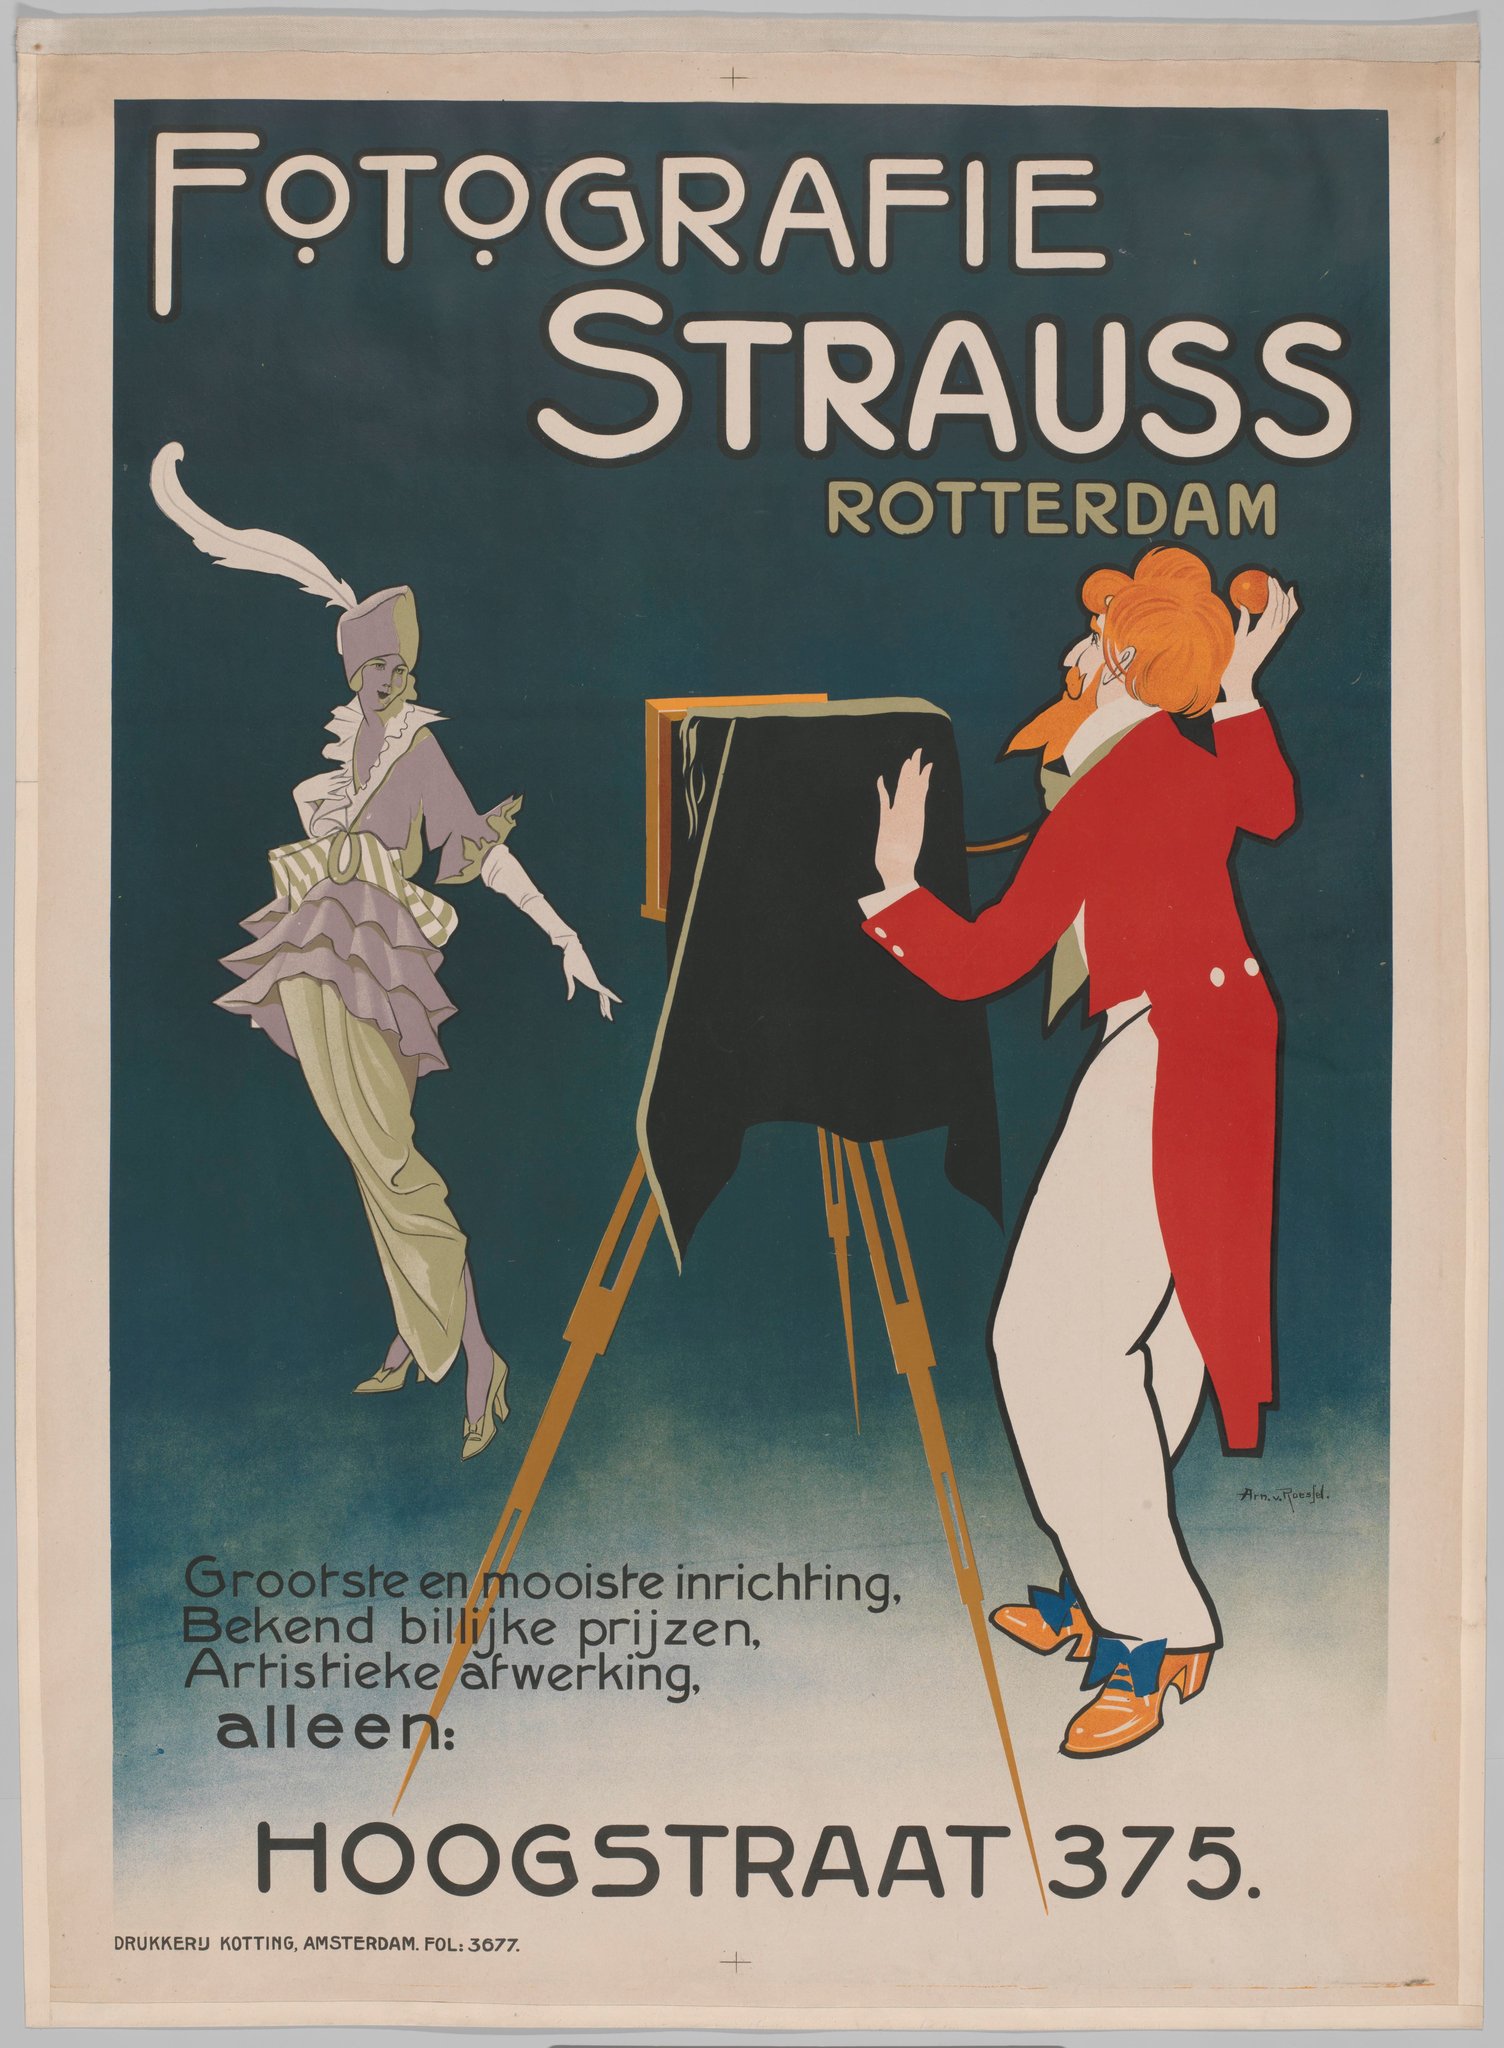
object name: poster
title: Fotografie Strauss Rotterdam. Grootste en mooiste inrichting. Bekend billijke prijzen. Artistieke afwerking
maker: arnold van roessel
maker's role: print maker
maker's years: 1883-1947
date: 1914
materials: paper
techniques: lithograph